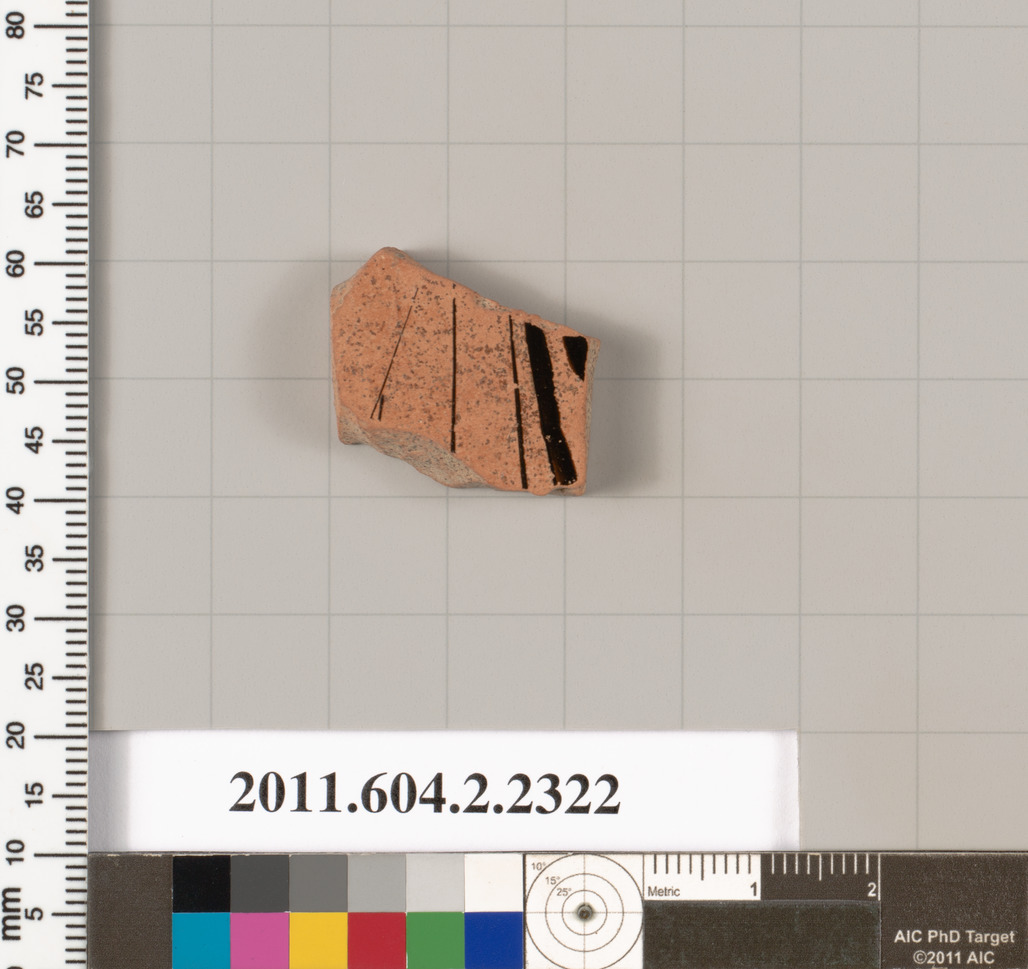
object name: skyphos fragment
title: Terracotta fragment of a skyphos (deep drinking cup)?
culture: greek, attic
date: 475-451 BCE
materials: terracotta